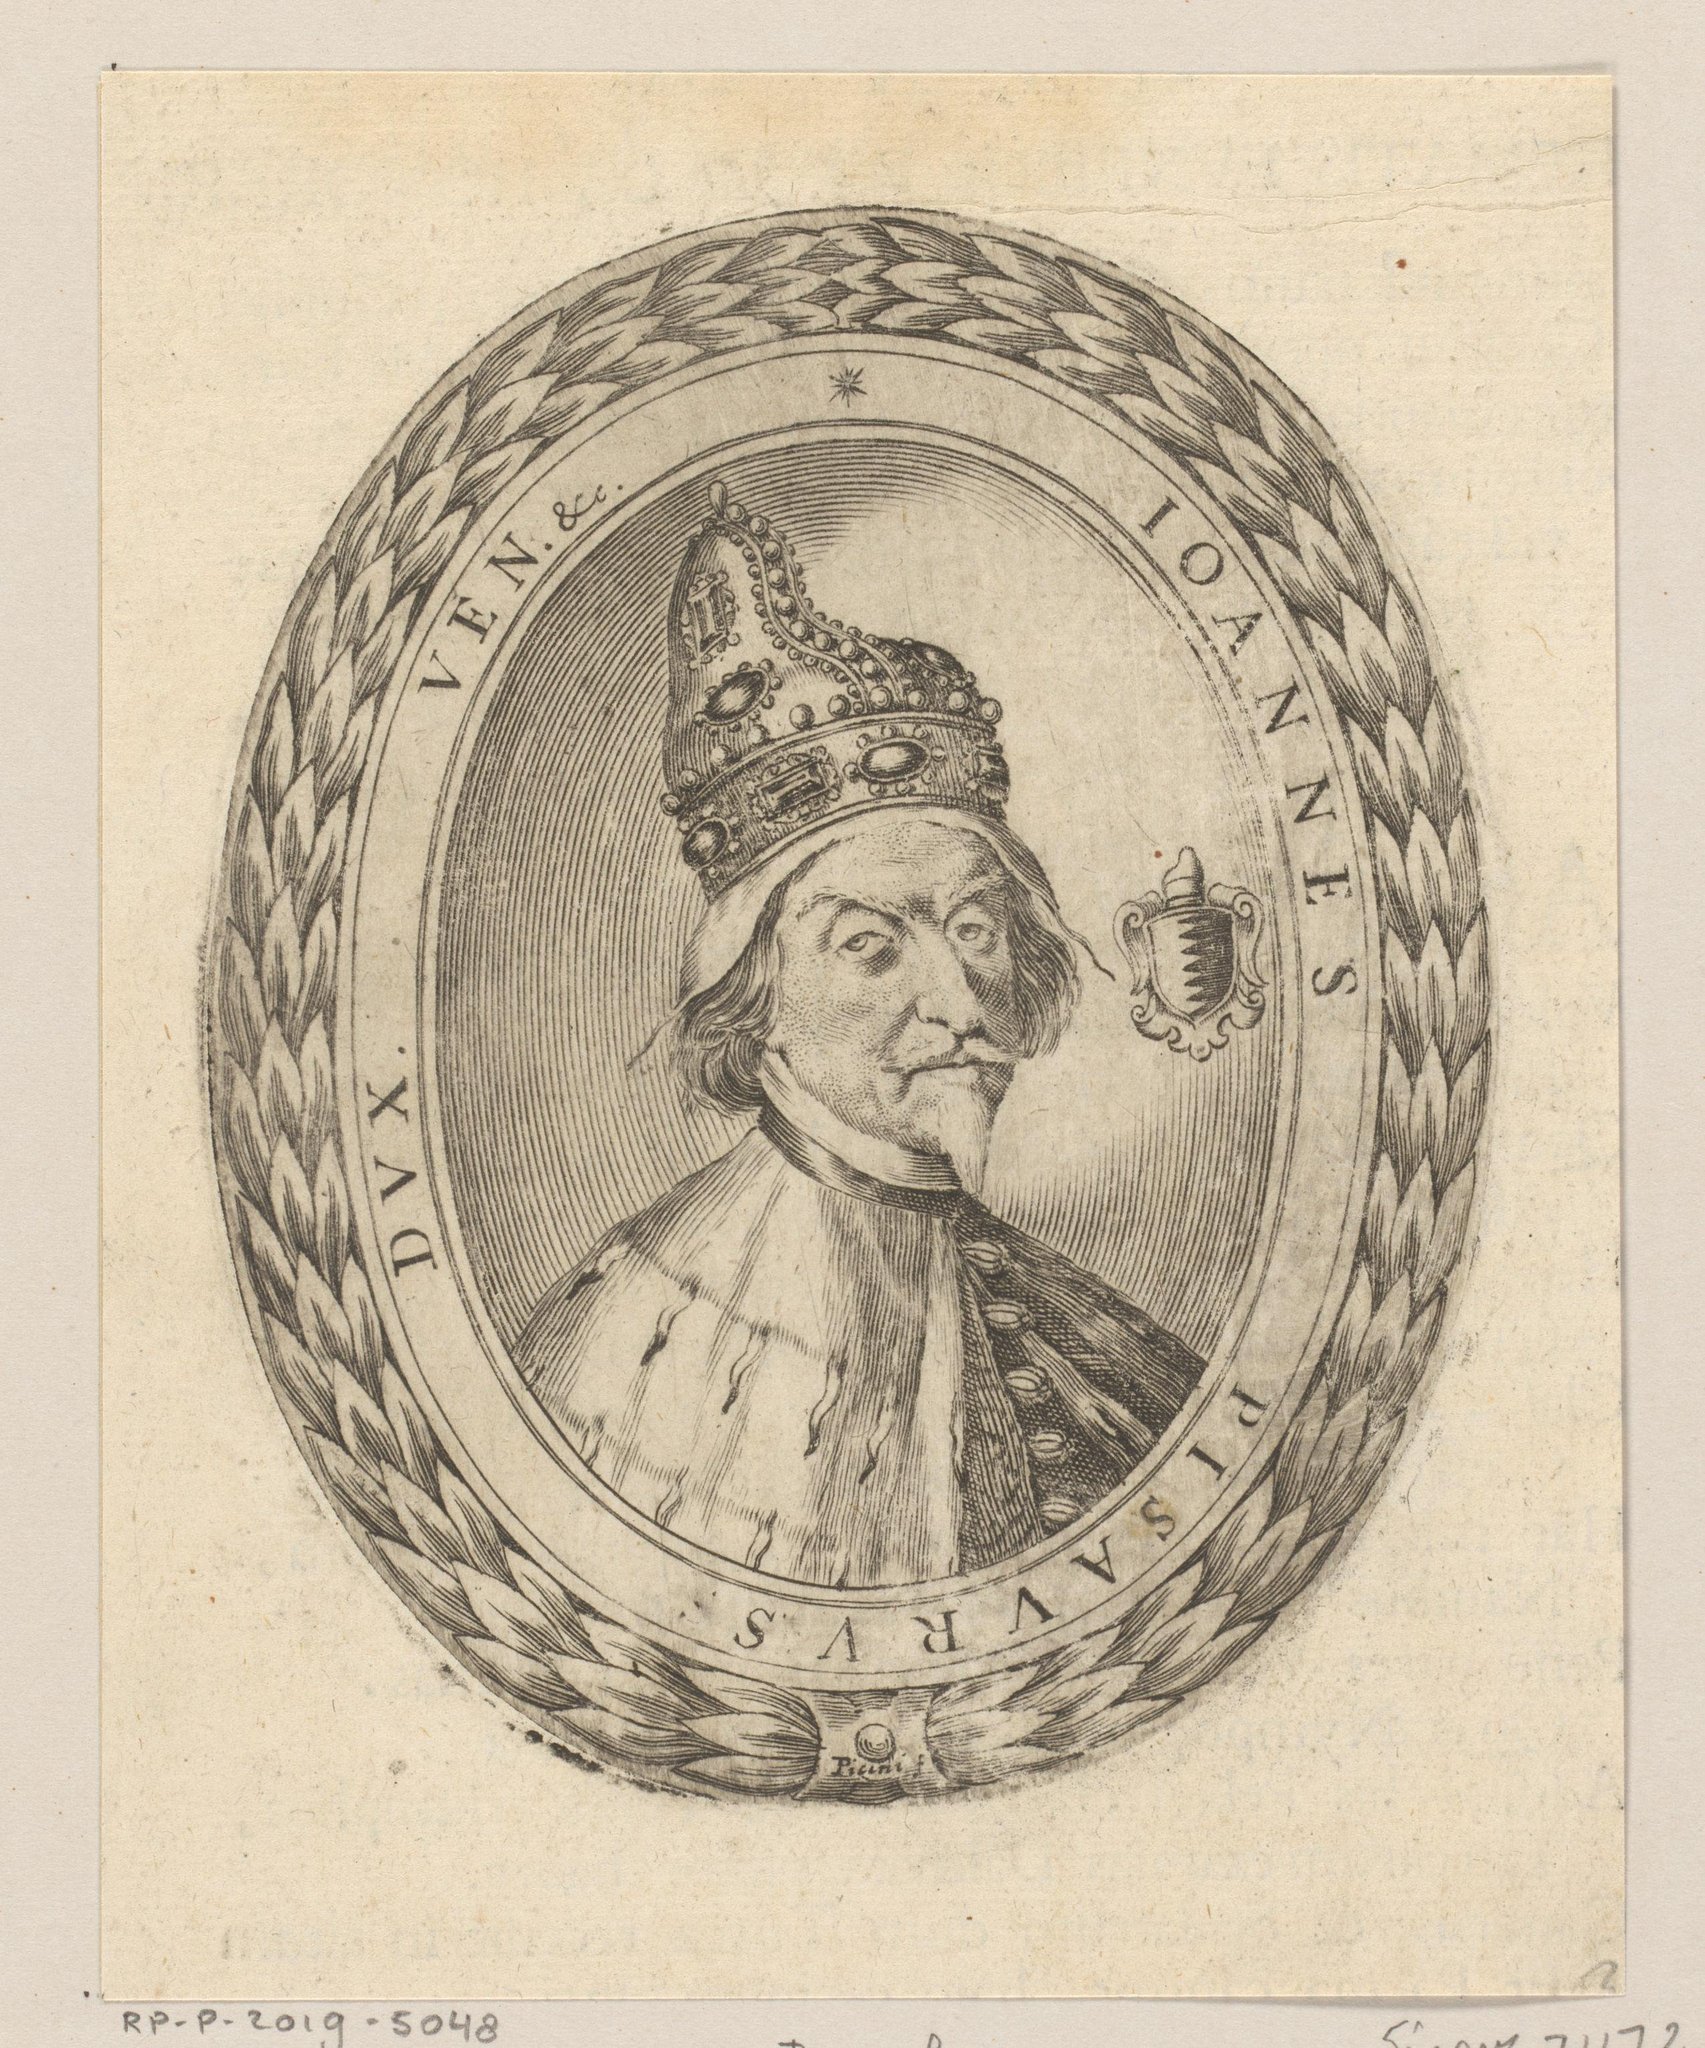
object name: print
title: Portret van Giovanni Pesaro, doge van Venetië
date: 1680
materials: paper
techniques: engraving, etching, letterpress printing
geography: padua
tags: historical persons, other sovereign: doge, armorial bearing, heraldry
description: Prent uit: Macedo, Francisco de. Elogia poetica in serenissimam Rempublicam Venetam, ejusque Augustum senatum tribunalia pontifices (...). Padua: Giacomo Cadorino, 1680.